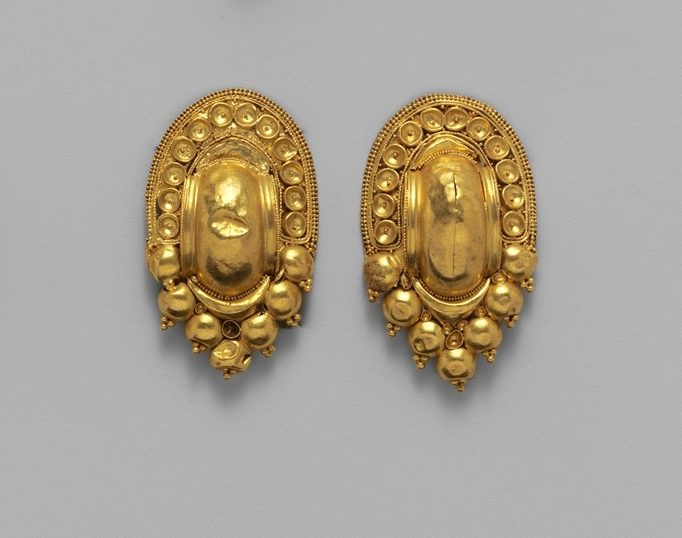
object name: earring, boat shaped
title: Gold earrings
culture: etruscan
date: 400-268 BCE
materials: gold